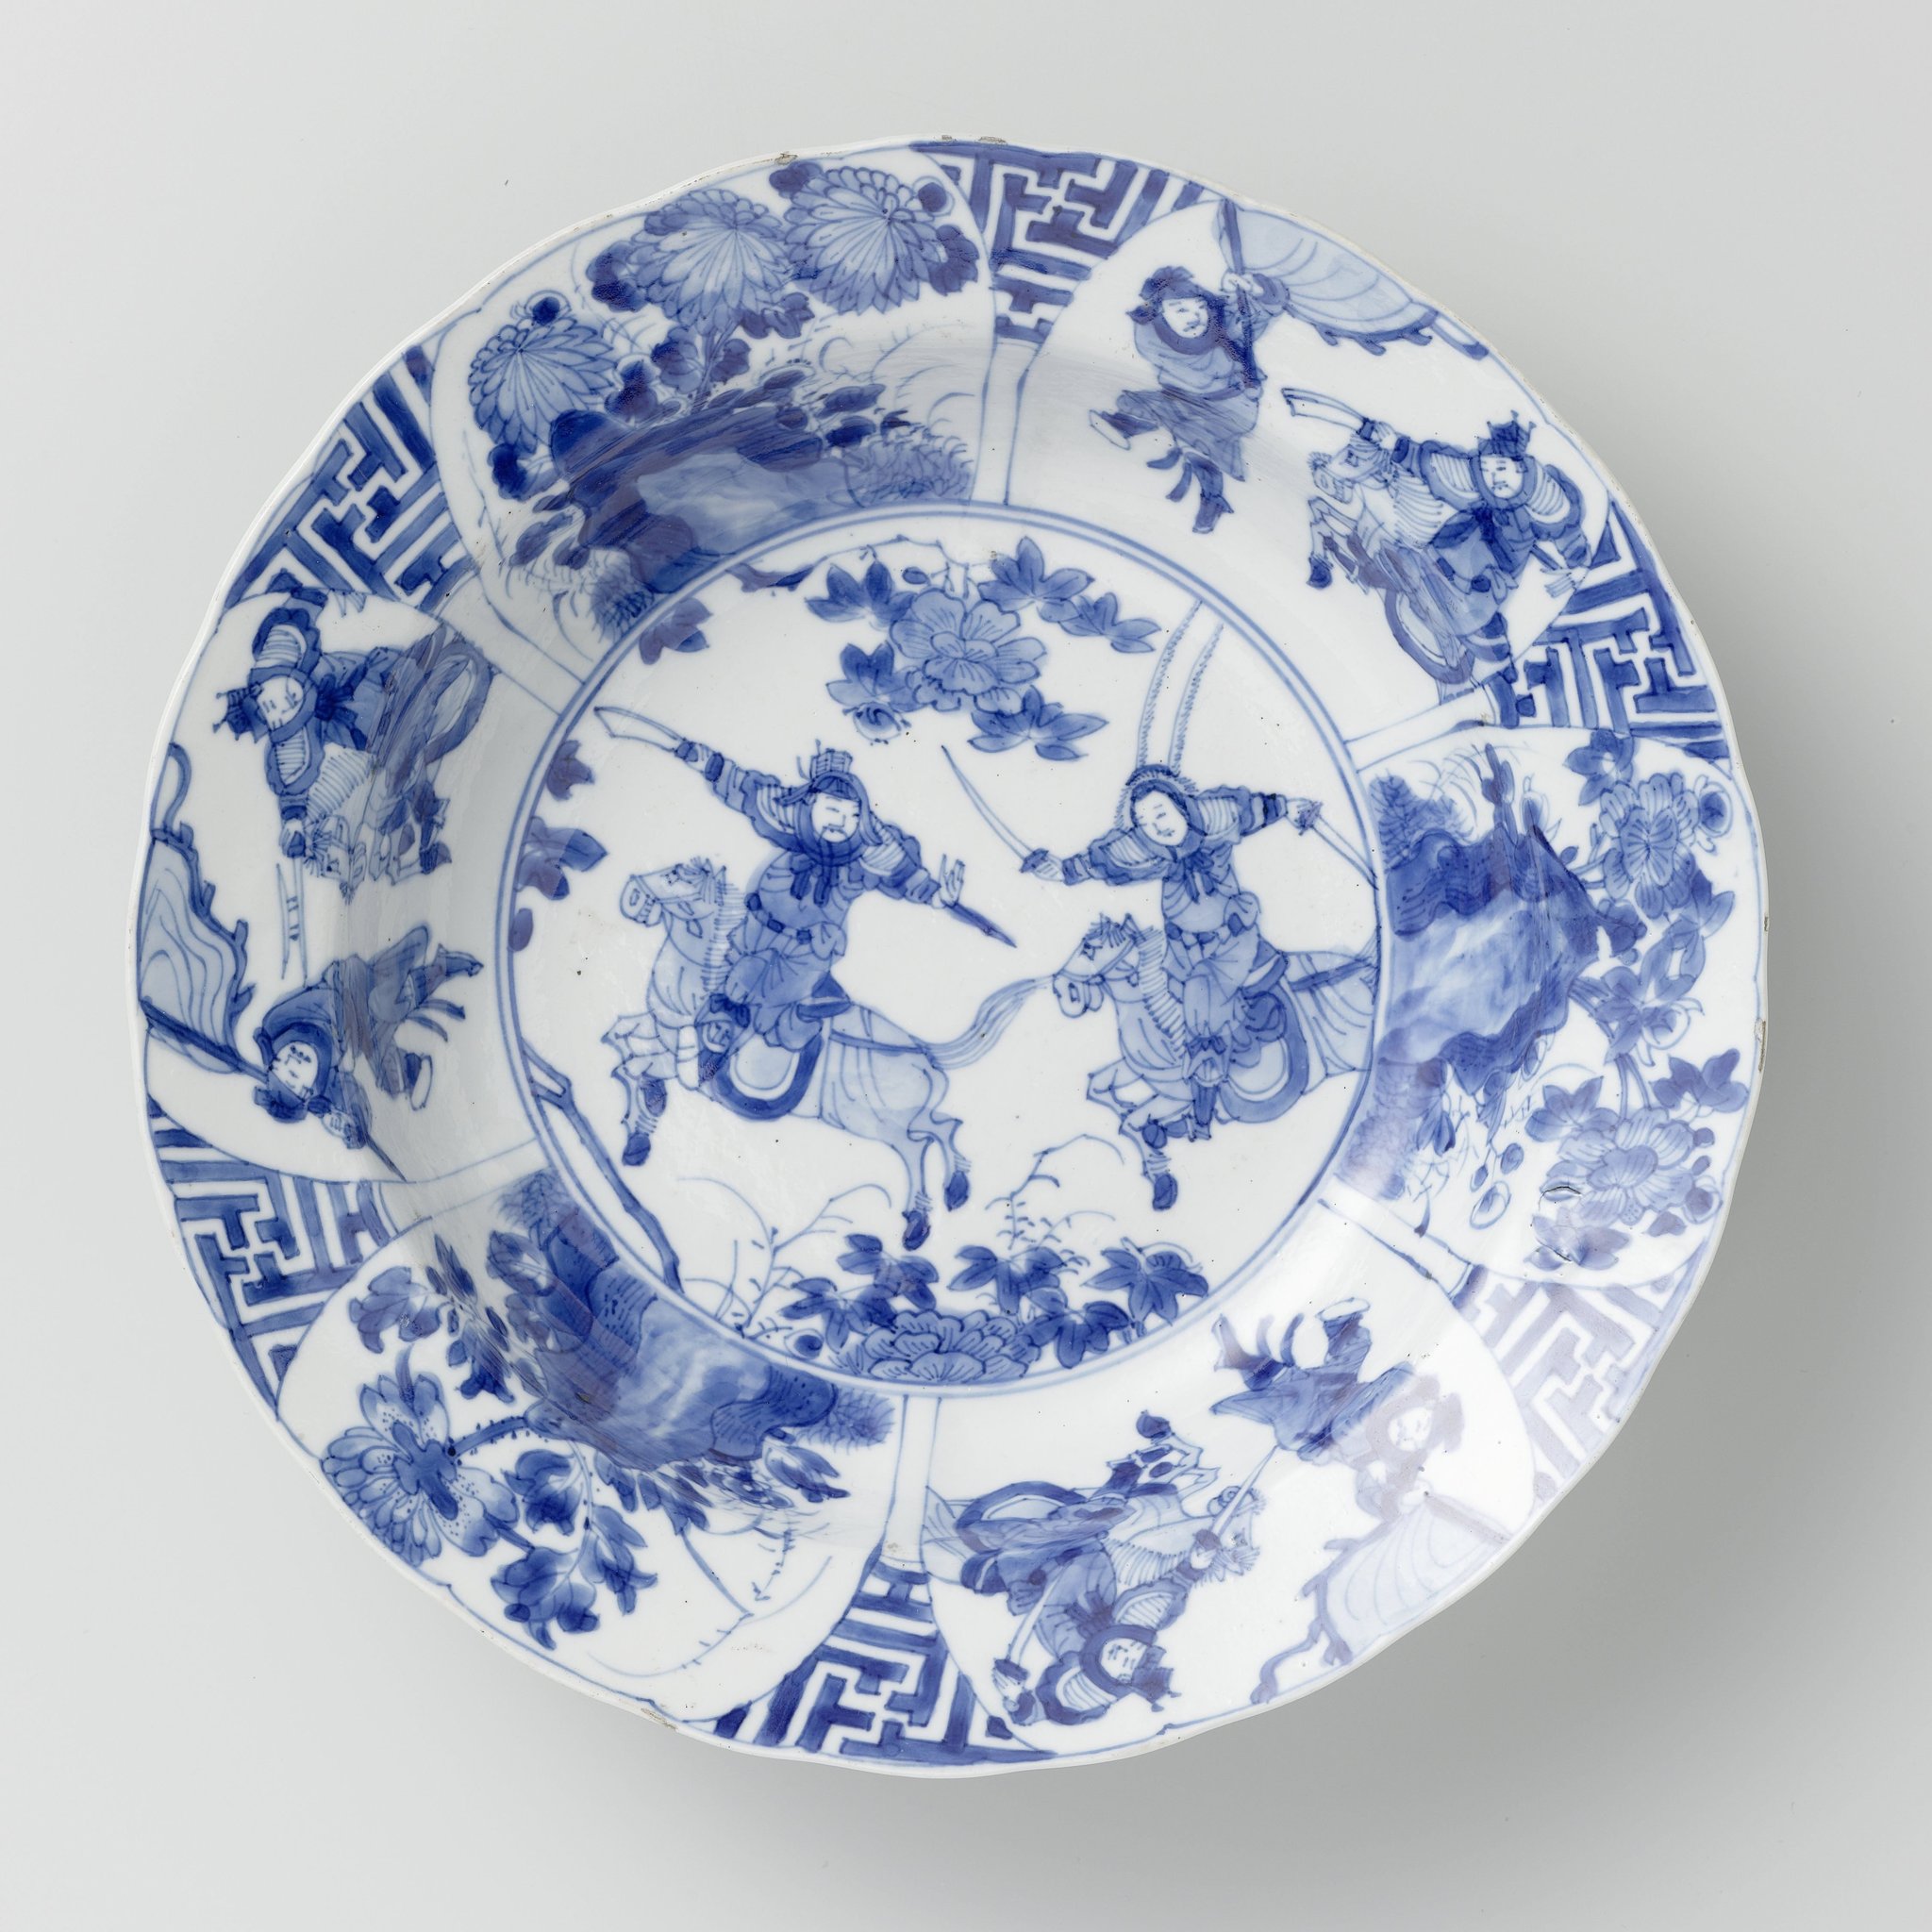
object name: plate dish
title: Deep plate with fighting horsemen and flowering plants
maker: Anonymous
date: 1680-1720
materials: cobalt, glaze, paint, porcelain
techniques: firing, turning, vitrification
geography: china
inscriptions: mark: ‘大 清 康 熙 年 製’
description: AK-NM-6854 Bord • Blauw-wit Kangxi-porselein • Onderdeel van Royers porseleincollectie • Oorspronkelijk twee exemplaren (inventaris Van der Kellen 1876) In het plat is een achtervolging weergegeven van twee krijgers te paard. Een vrouw achtervolgt een man. Waarschijnlijk is het een scène uit het verhaal van Fan Lihua die Yang Fan wegjaagt, de man die haar familie voor haar heeft uitgekozen om mee te trouwen. Zelf heeft zij haar zinnen gezet op een ander, Xue Dingshan [Cheng 2009, nr. 59]. Hoe de kleinere scenes in de rand zich hiertoe verhouden is mij niet geheel duidelijk. De swastika in de rand is interessant in verband met de associaties die bij de kom AK-NM-6845 ter sprake kwamen én omdat dit motief op kraakschotels bekend is als opvulling rond de voorstelling in het plat en hier op een andere manier terugkeert. Deze manier van decoreren – de verhalende voorstelling gebaseerd op een houtsnede is nog verwant aan de praktijk uit de Overgangsperiode, maar hier is het al meer een geïsoleerd element dat tegen een vrijwel lege achtergrond wordt geschilderd. De geheel geïsoleerde ‘lijs’ is een volgende fase in die ontwikkeling (zie bijvoorbeeld het vaasje AK-NM-6723). Dit stuk is gemerkt met een groot zes karakter merk Kangxi. Dit moet Royers aandacht hebben gehad, gezien zijn grote inspanningen om de Chinese taal te leren en zijn gewoonte in lange lijsten karakters te noteren die hij waar dan ook kon vinden, met hun betekenis en aantekeningen over de juiste uitspraak. Dit merk kon hij lezen. In zijn aantekenboek had hij een chronologie van de Chinese keizer-perioden opgenomen, geheel in Chinese karakters uitgeschreven. Kangxi komt daar uiteraard ook in voor [OR 8966, fol. 85]. In zijn belangstelling voor deze inscripties stond Royer niet alleen. Margaret Bentinck, Duchess of Portland (17150-1785) was een groot porseleinliefhebber in Engeland. In 1775 ontving zij Whang at Tong, een Chinees die de Engelse amateur-botanicus John Bradby Blake (1745-1773) assisteerde in Kanton en na diens overlijden diens botansiche materiaal naar Engeland begeleidde. Van Whang at Tongs hand is een lijst met meest voorkomende merken bewaard met daarbij zijn vertaling en toelichtingen [vriendelijke mededeling Menno Fitski en Clark 2017, p. 514]. Meer in het algemeen duidt het vrij veel voorkomende gebruik van faienceschilders om fantasie-merken en -inscripties op hun werkstukken aan te brengen, op een fascinatie voor deze merken [Van Noord 2020]. Een laatste opmerking over dit bord gaat over de liefde voor dit type schotels aan het eind van de 19de en het begin van 20ste eeuw, als de porseleinliefde opnieuw opbloeit. Sommige stukken werden ‘musts’ voor de verzamelaars en dat gold ook voor deze schotels, liefst de iets grotere variant. B.J.V. Van Hees (1873-1953), een van de meest vooraanstaande Nederlandse porselein verzamelaars uit die tijd, had er ‘vanzelfsprekend’ een [Cheng 2009, nr. 59], het Rijksmuseum heeft een ander exemplaar dat afkomstig is uit de collectie van de zeer welgestelde bankier en kunstverzamelaar Adriaan van der Hoop (1778-1854) (AK-NM-13175). Hendricus Adolphus Steengracht (1836-1912) was porseleinverzamelaar en bewoner van kasteel Duivenvoorde, waar hij veel verbouwde en verfraaide. Passend voor zijn tijd, wilde hij het verleden zichtbaar maken. De hal, met een uitstraling van een voorname vroeg-17de-eeuwse ridderlijke woning, werd aangekleed met een ensemble van grote vazen, bloempotten en een serie van zes van deze borden [Van Campen 2010 pp. 191-192]. Voor de vazen en potten werden speciaal voeten gemaakt, de borden kregen houten lijsten met snijwerk, gebaseerd op vroeg 17de-eeuwse ornamenten, zwart gemaakt, met gouden accenten. Het porselein werd ingekaderd in een (fantasie) Nederlands historisch kader. Blijkbaar leenden een serie van deze borden zich voor het beeld van Chinees porselein voor de Nederlandse Gouden Eeuw. Bronnen: Cheng Xiejun (red.), Traces of the trade: Chinese export porcelain donated by Henk B. Nieuwenhuys (tent.cat. Shanghai Museum), Shanghai, 2009. Jan van Campen, ‘Exotisch pronken’, in: Annette de Vries (red.), Duivenvoorde. Bewoners, landgoed, kasteel, interieur en collectie, Zwolle/Voorschoten, 2010, pp. 185-195. David Clarke, ‘Chinese visitors to 18th Century Britain and their contribution to its cultural and intellectual life’, Curtis’s Botanical Magazine 34/4 (2017), pp. 498-521. Willemijn van Noord, ‘Between Script and Ornament: Delftware Decorated with Pseudo Chinese Characters, 1680—1720, Journal of Design History 34/1 (2020), online.